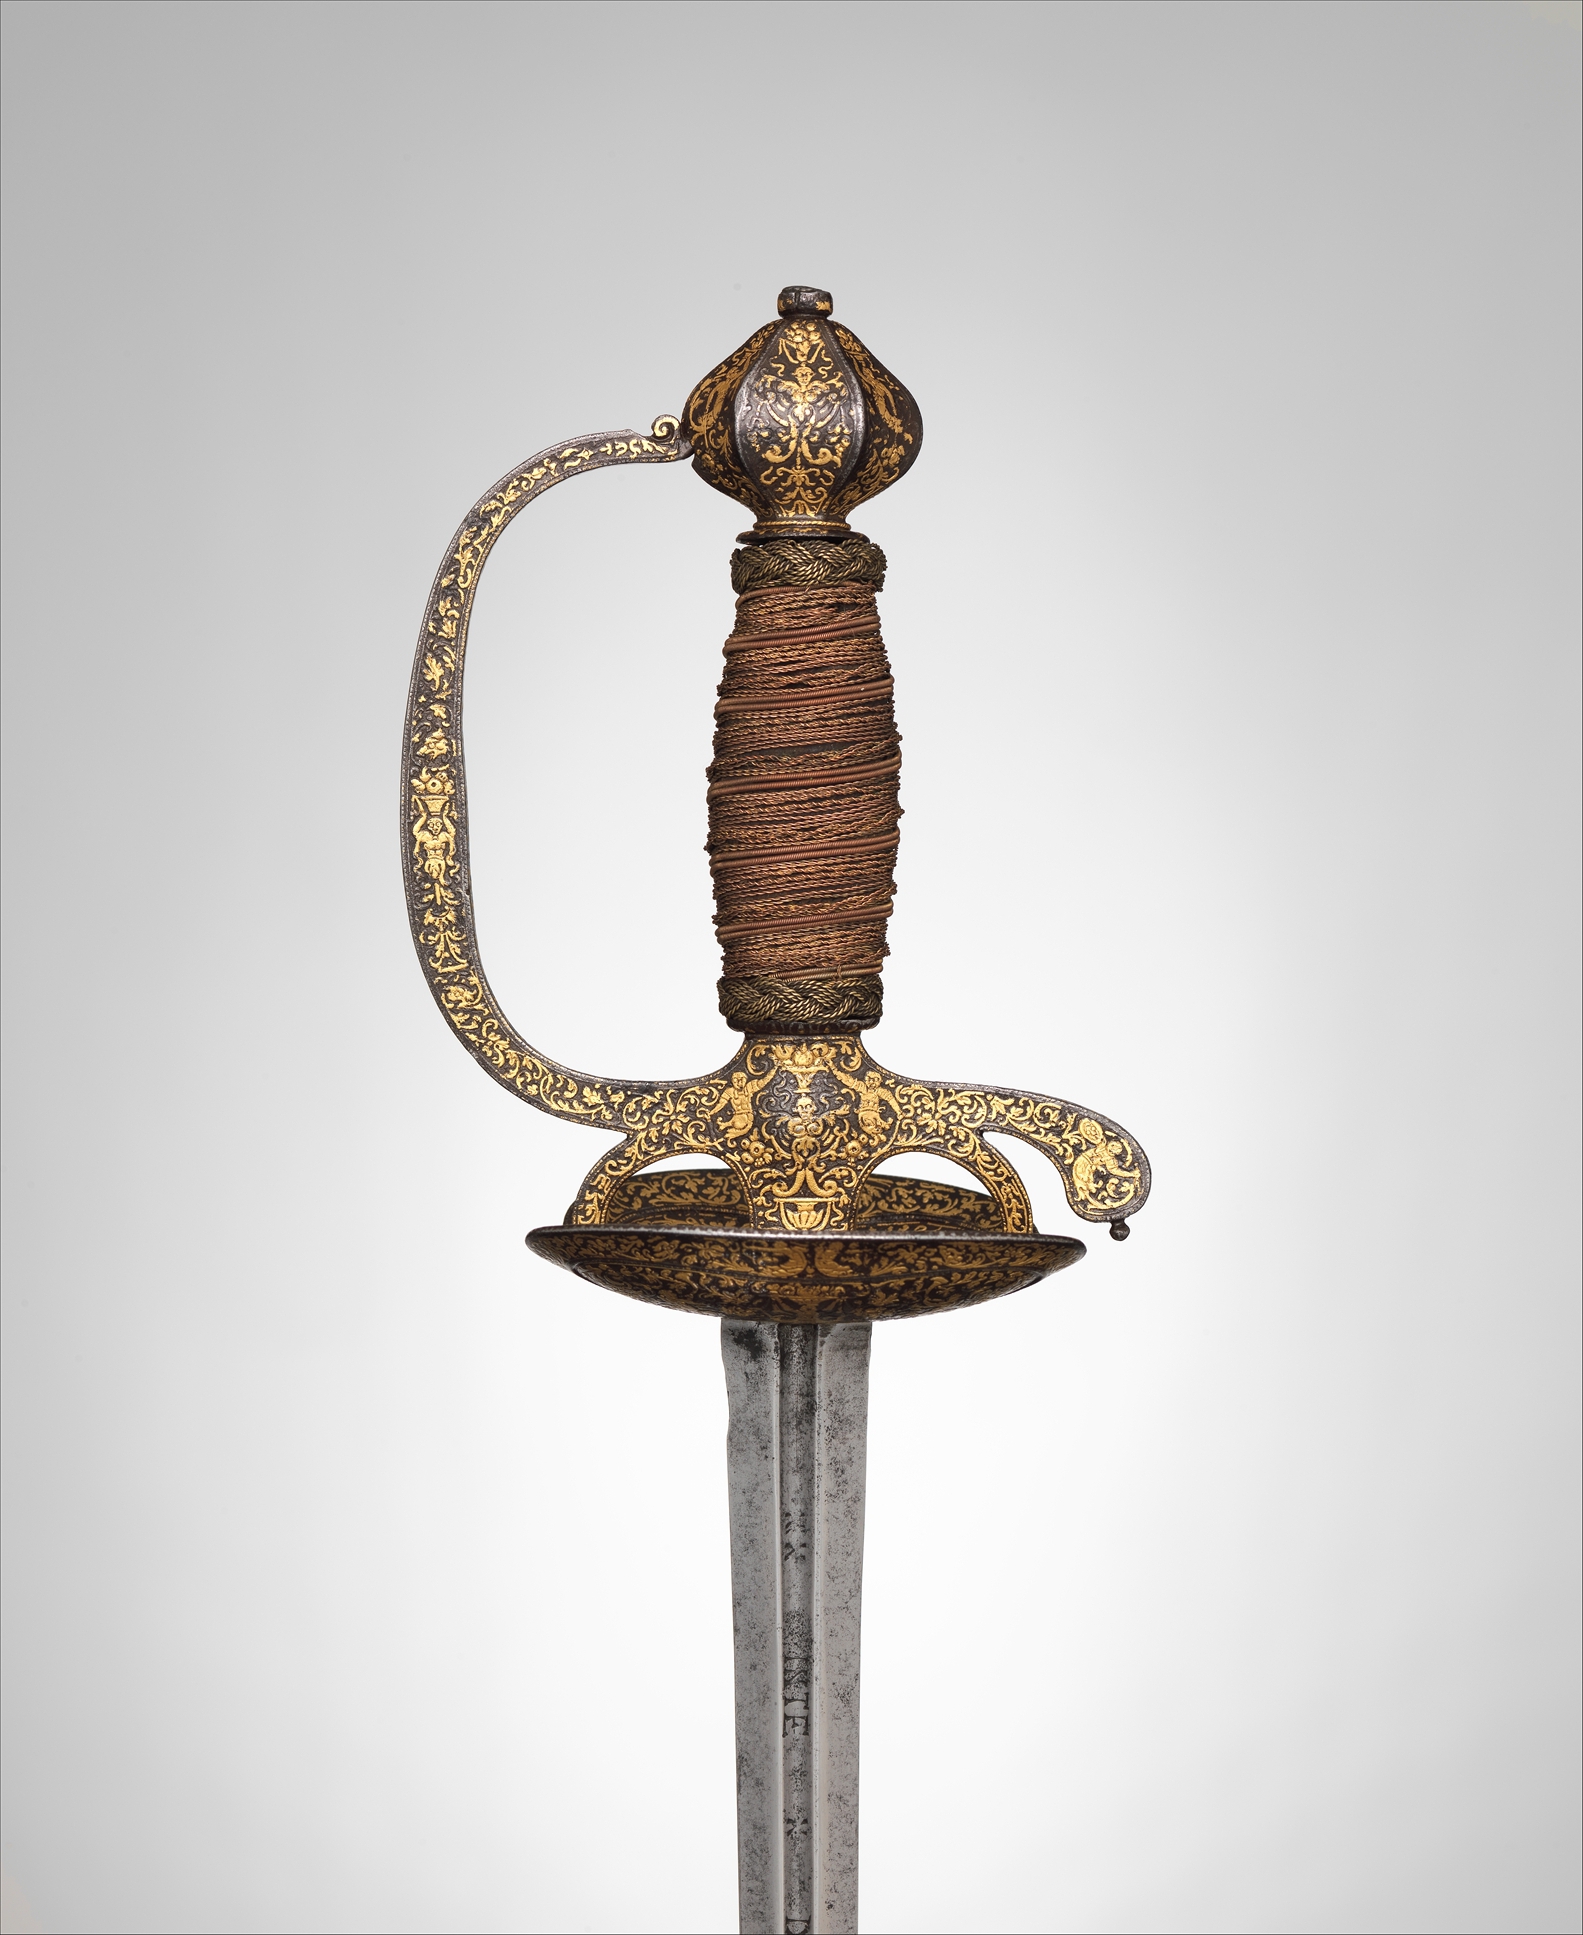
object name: smallsword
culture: french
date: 1650-1660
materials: copper alloy, gold, steel, wood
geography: france